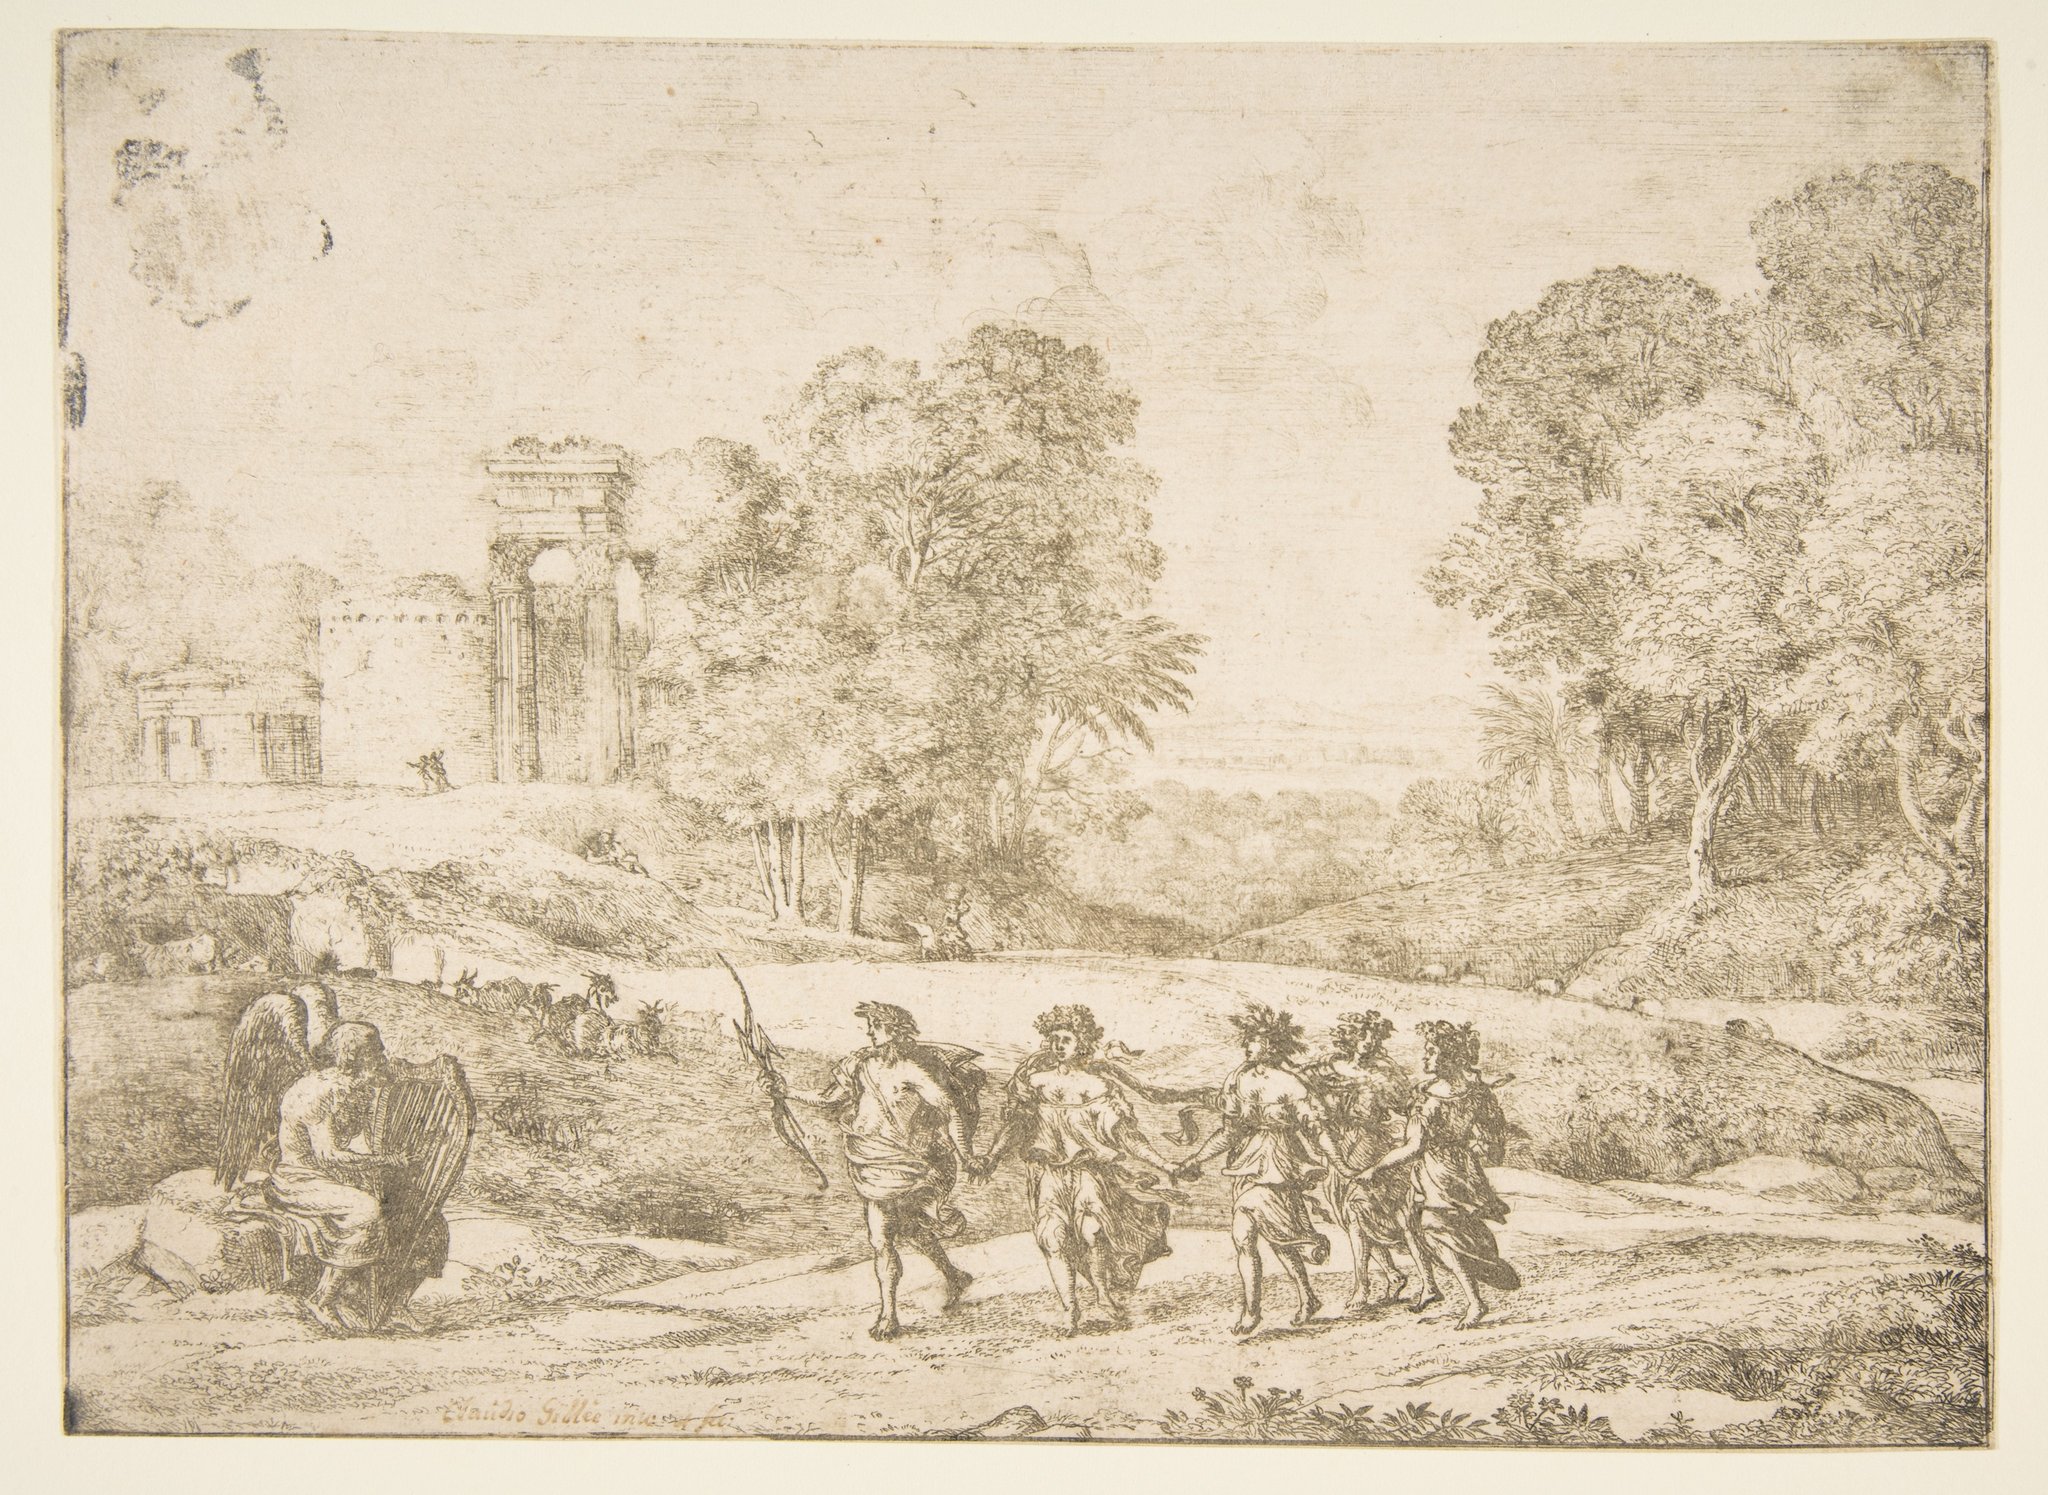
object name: print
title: Time, Apollo and the Seasons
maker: claude lorrain (claude gellée)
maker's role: artist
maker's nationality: french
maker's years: 1604-1682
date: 1662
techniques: etching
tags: bow and arrow,women,apollo